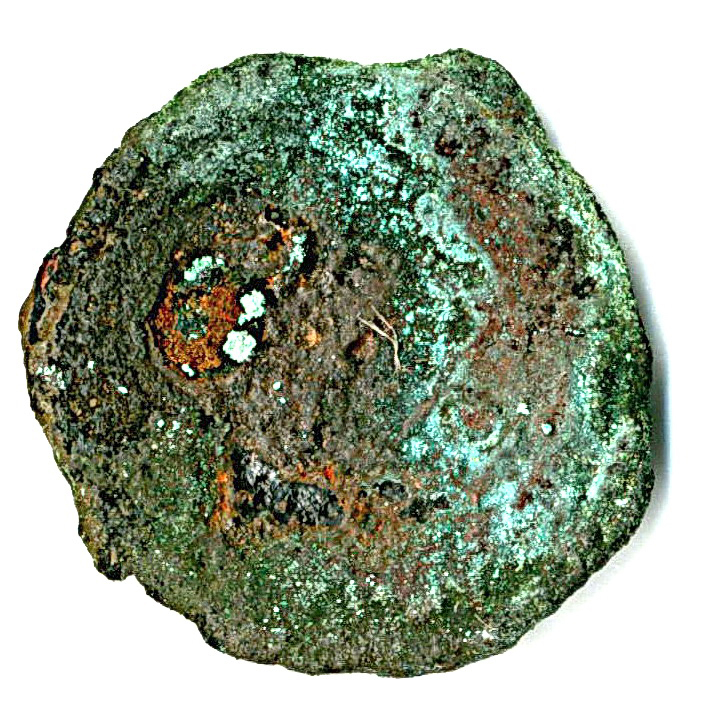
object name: coin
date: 701-800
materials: copper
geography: iran